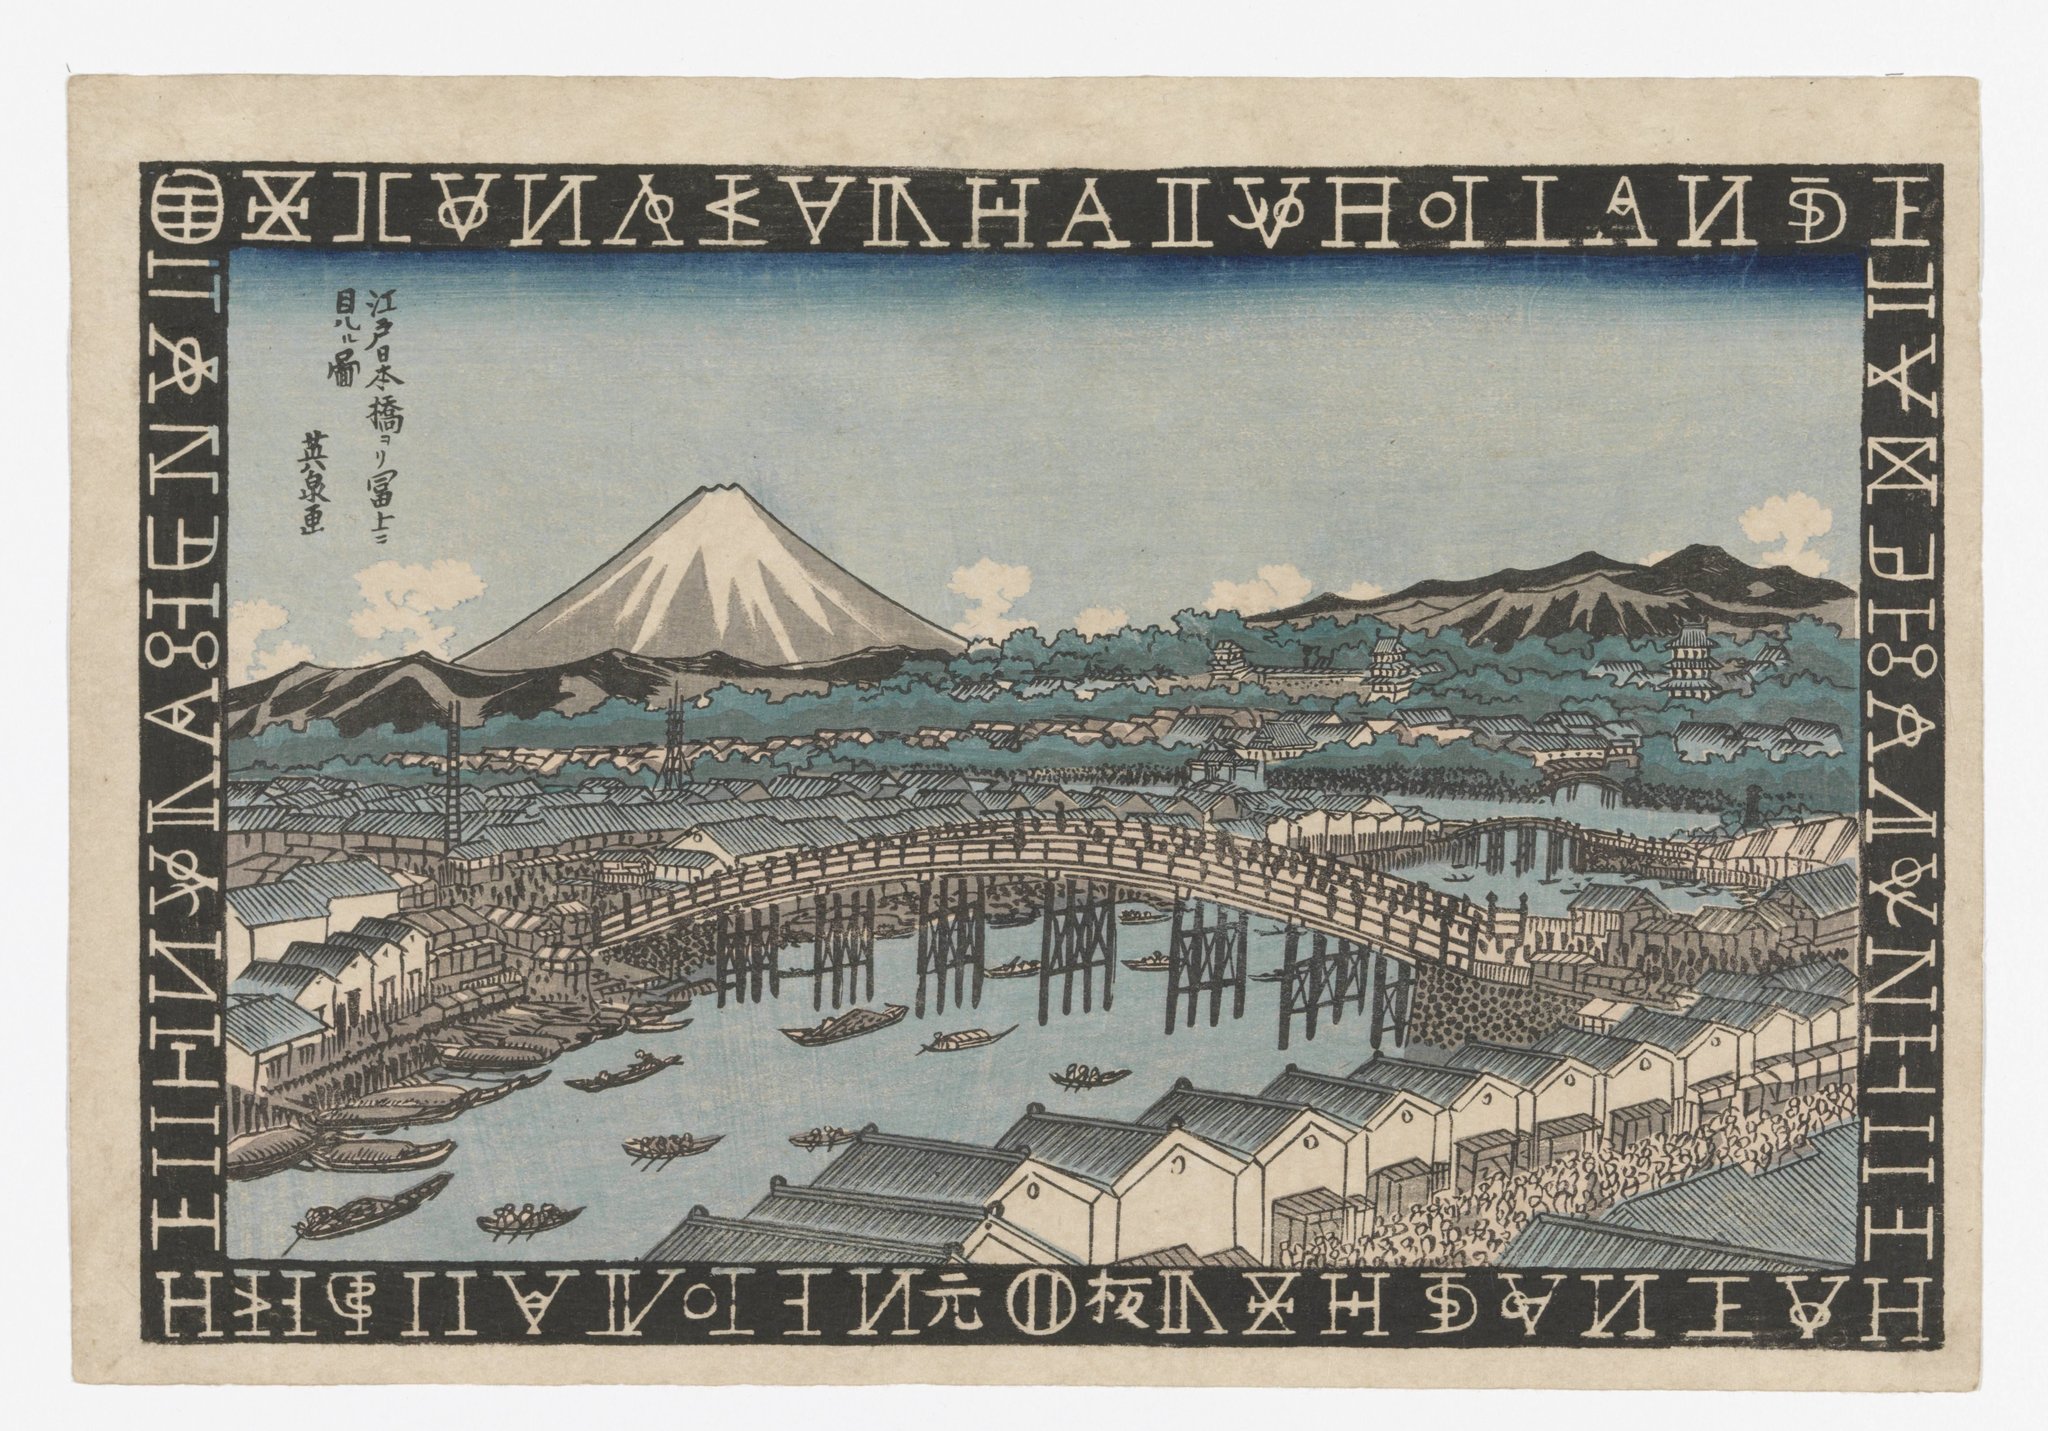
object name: print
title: Mount Fuji as seen from Nihonbashi in Edo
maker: keisai eisen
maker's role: print maker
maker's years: 1790-1848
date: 1827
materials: paper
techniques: woodcut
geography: japan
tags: city-view in general; 'veduta'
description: Gezicht op de pleisterplaats Nihonbashi met de gelijknamige brug en de berg Fuji op de achtergrond. Rondom de voorstelling een gedrukte lijst met in ‘westers’ schrift o.a het woord ‘Holland’ en het VOC symbool.